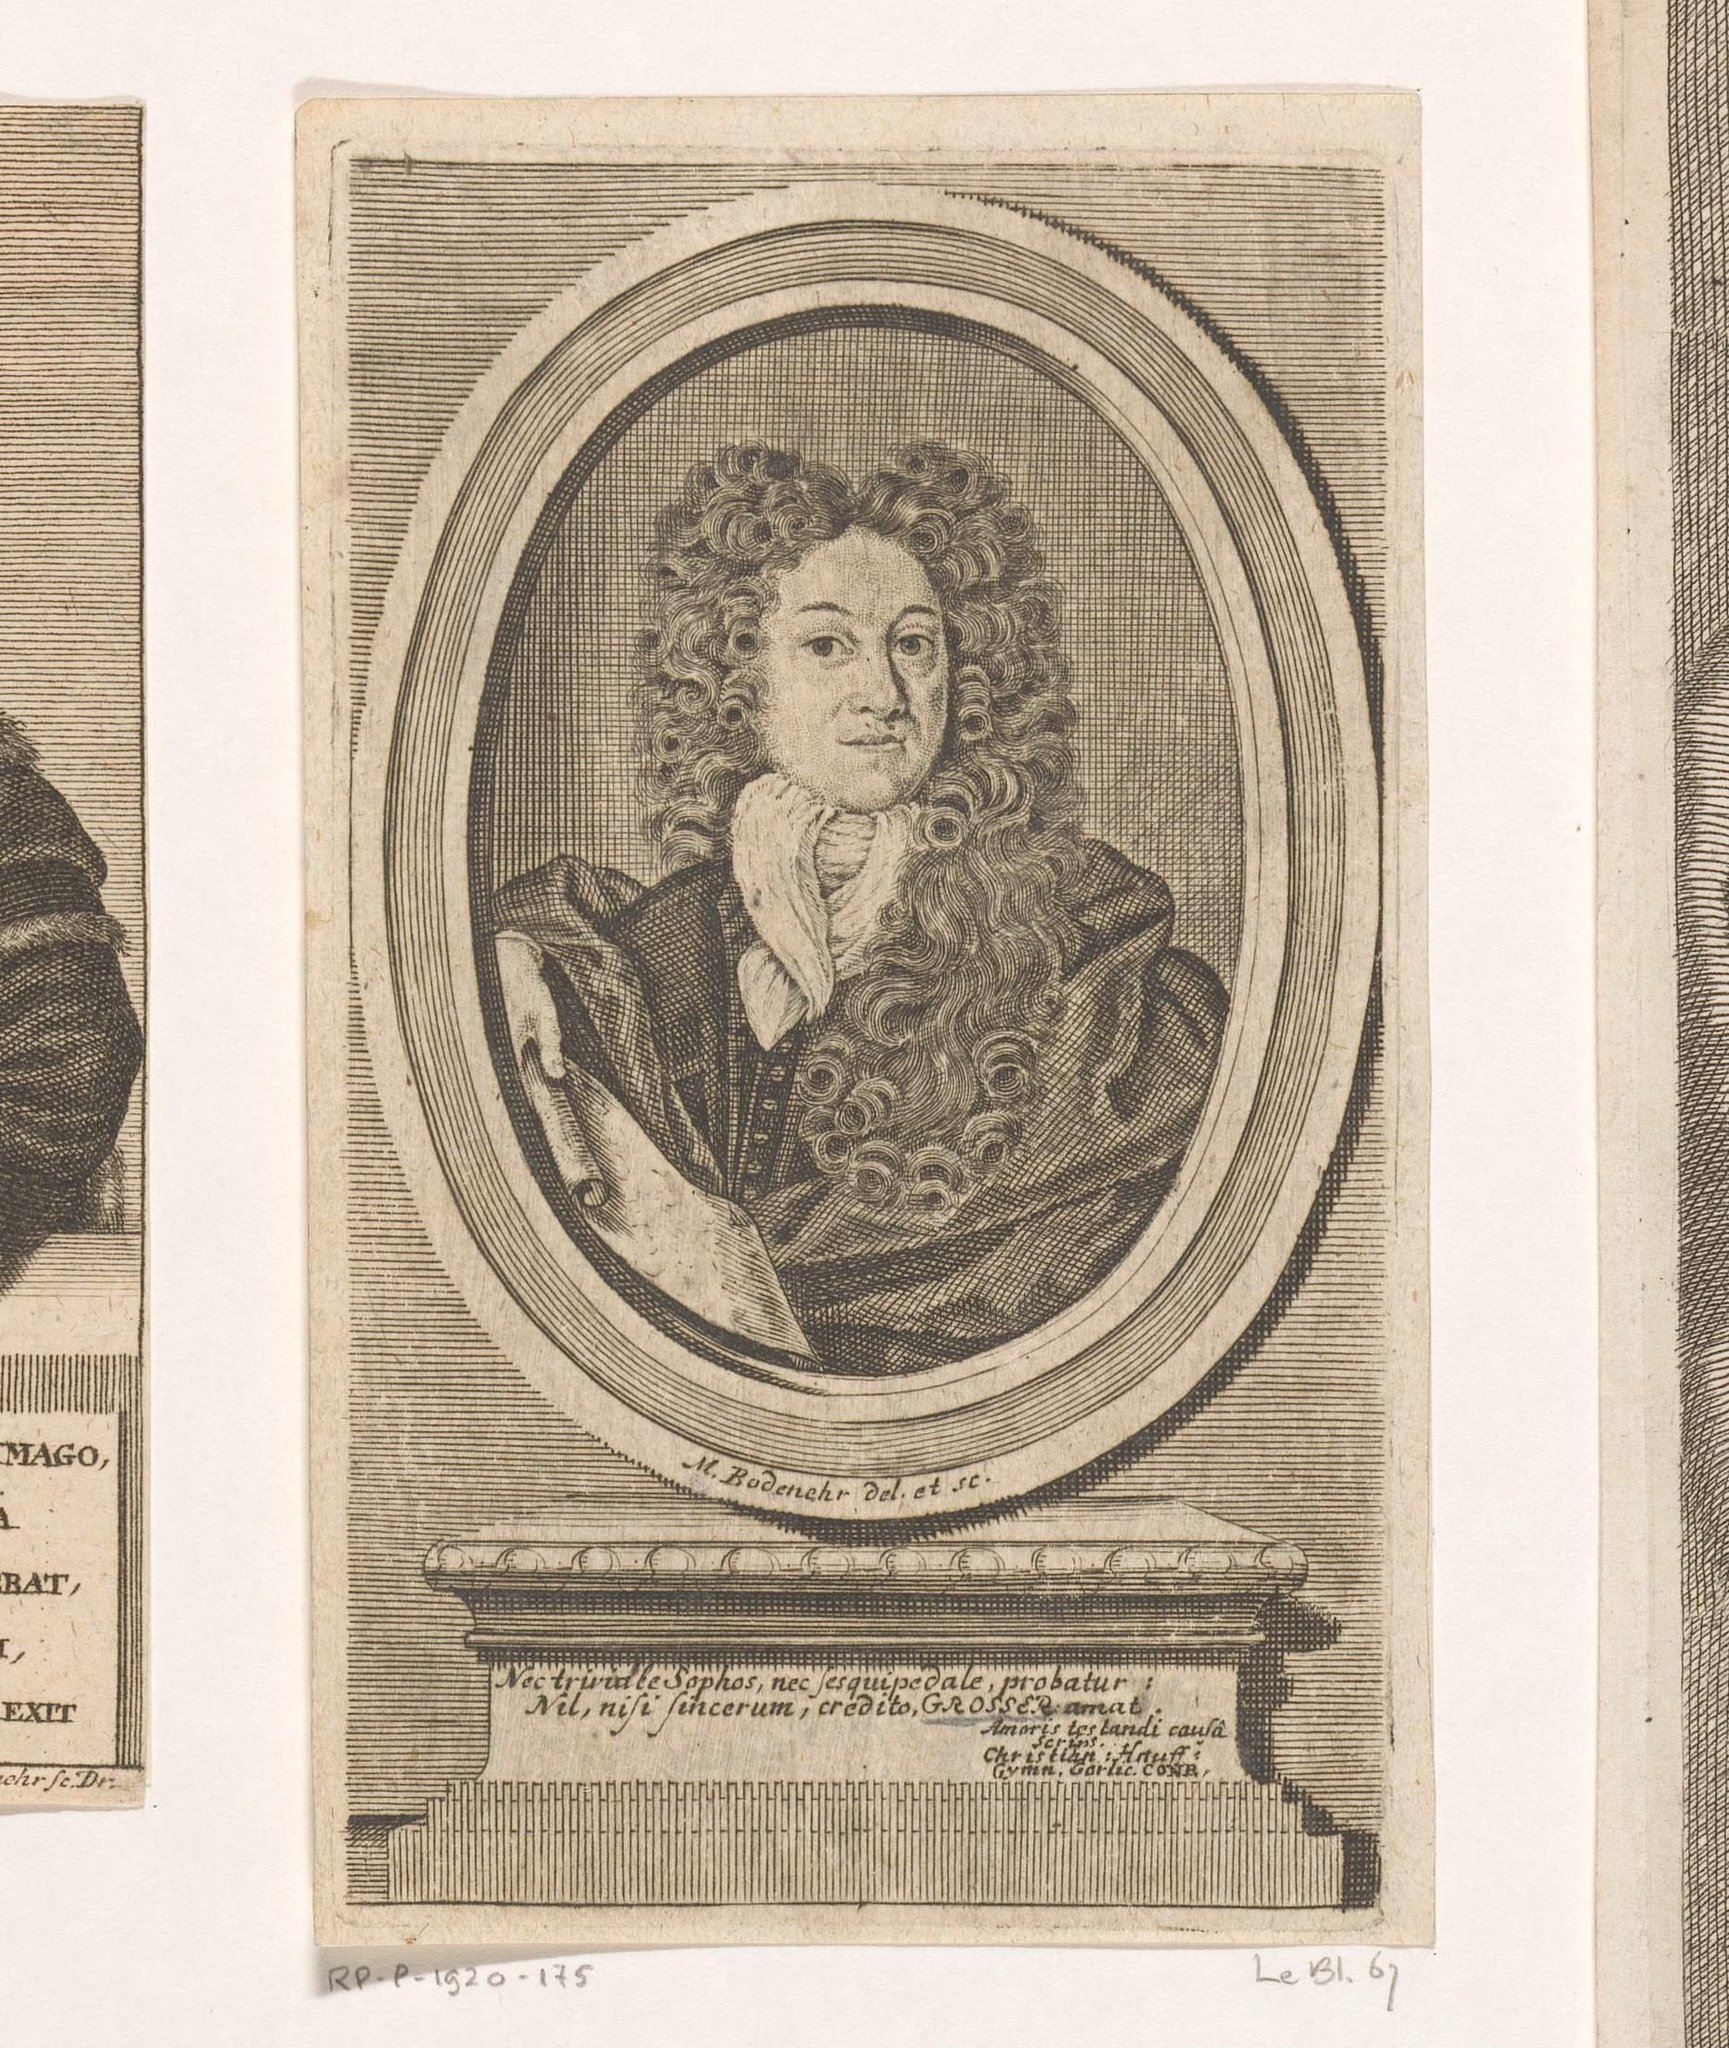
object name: print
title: Portret van Paolo Zacchia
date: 1816-1833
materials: paper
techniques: lithograph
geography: paris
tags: historical persons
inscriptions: collector's mark: Lugt 2228